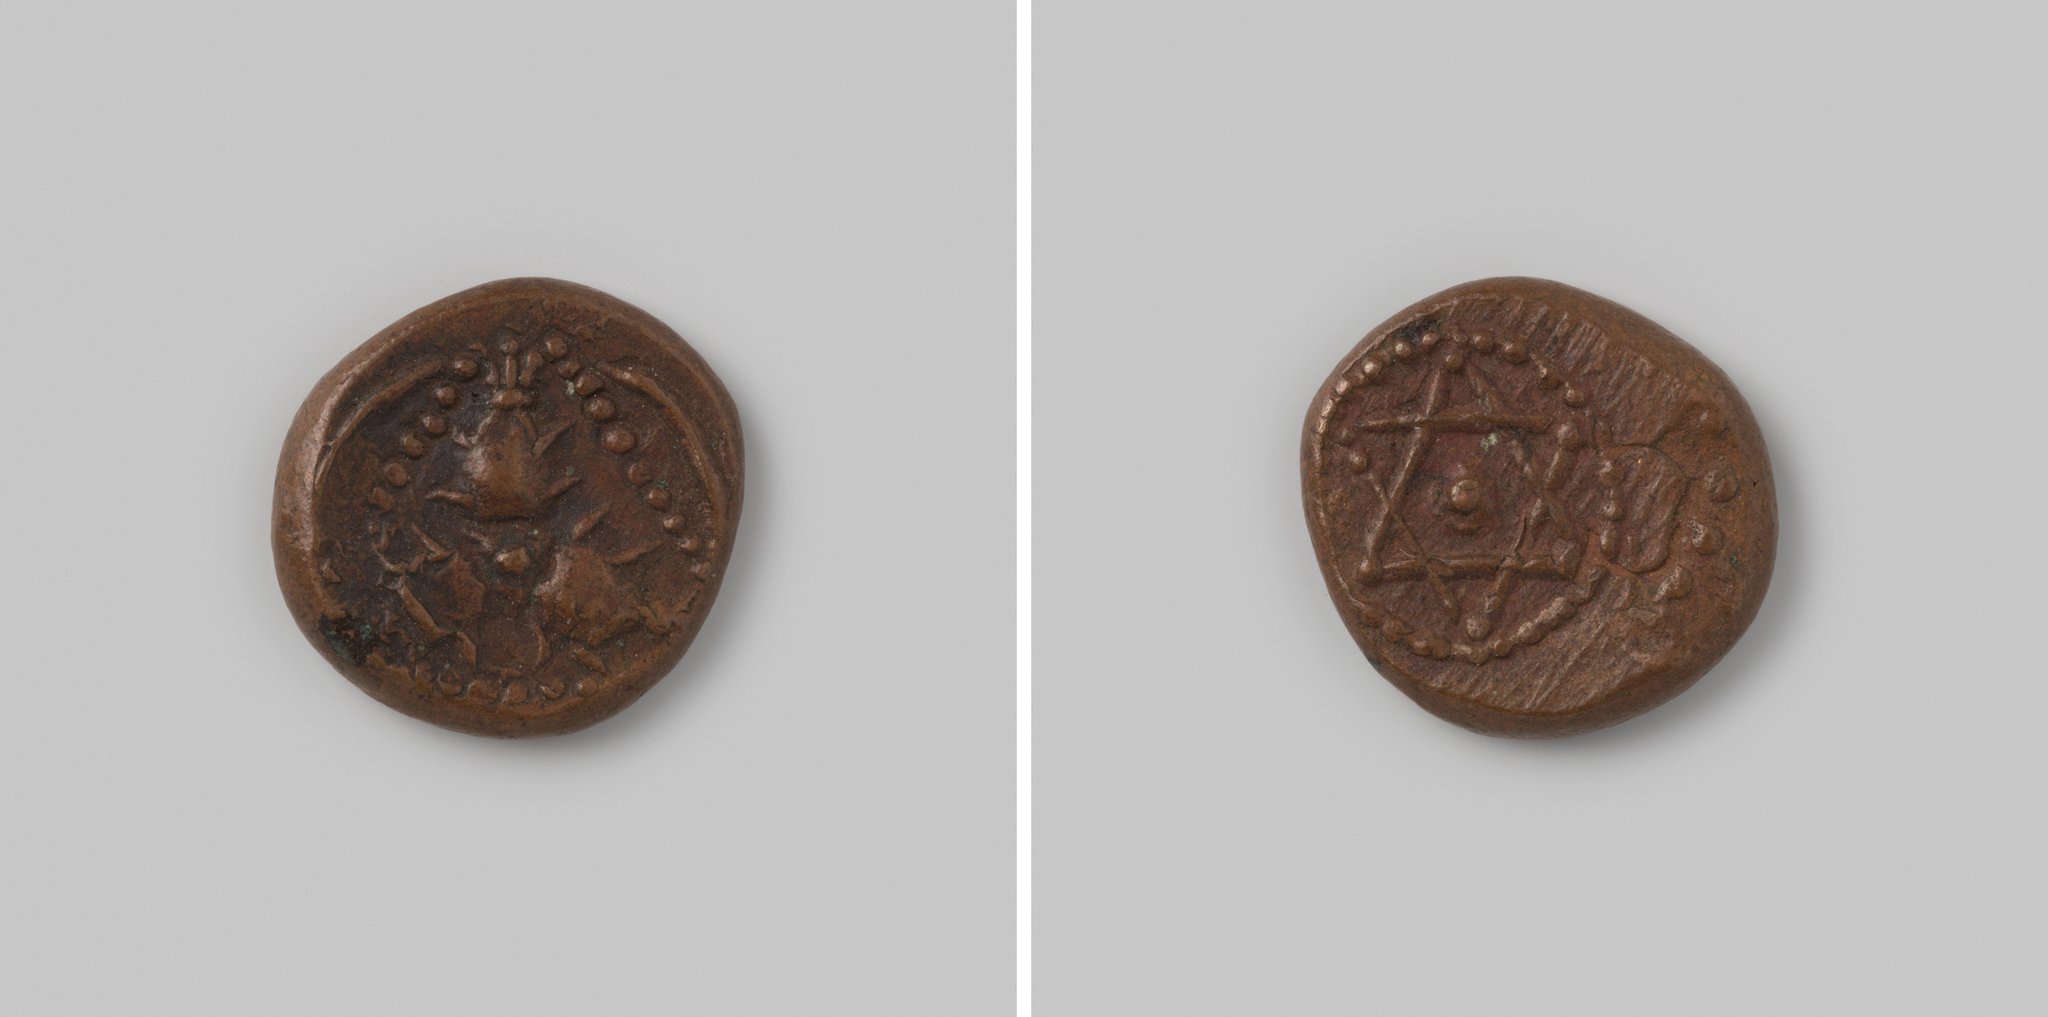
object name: coin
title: India,Travancore, koperen doedoe van 4 cash,1800-1900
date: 1800-1900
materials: copper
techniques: striking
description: Koperen munt. Voorzijde: binnen gelijkbenige driehoek symbolische tekens. Keerzijde: binnen cirkel zesspuntige ster met in het midden een stip.